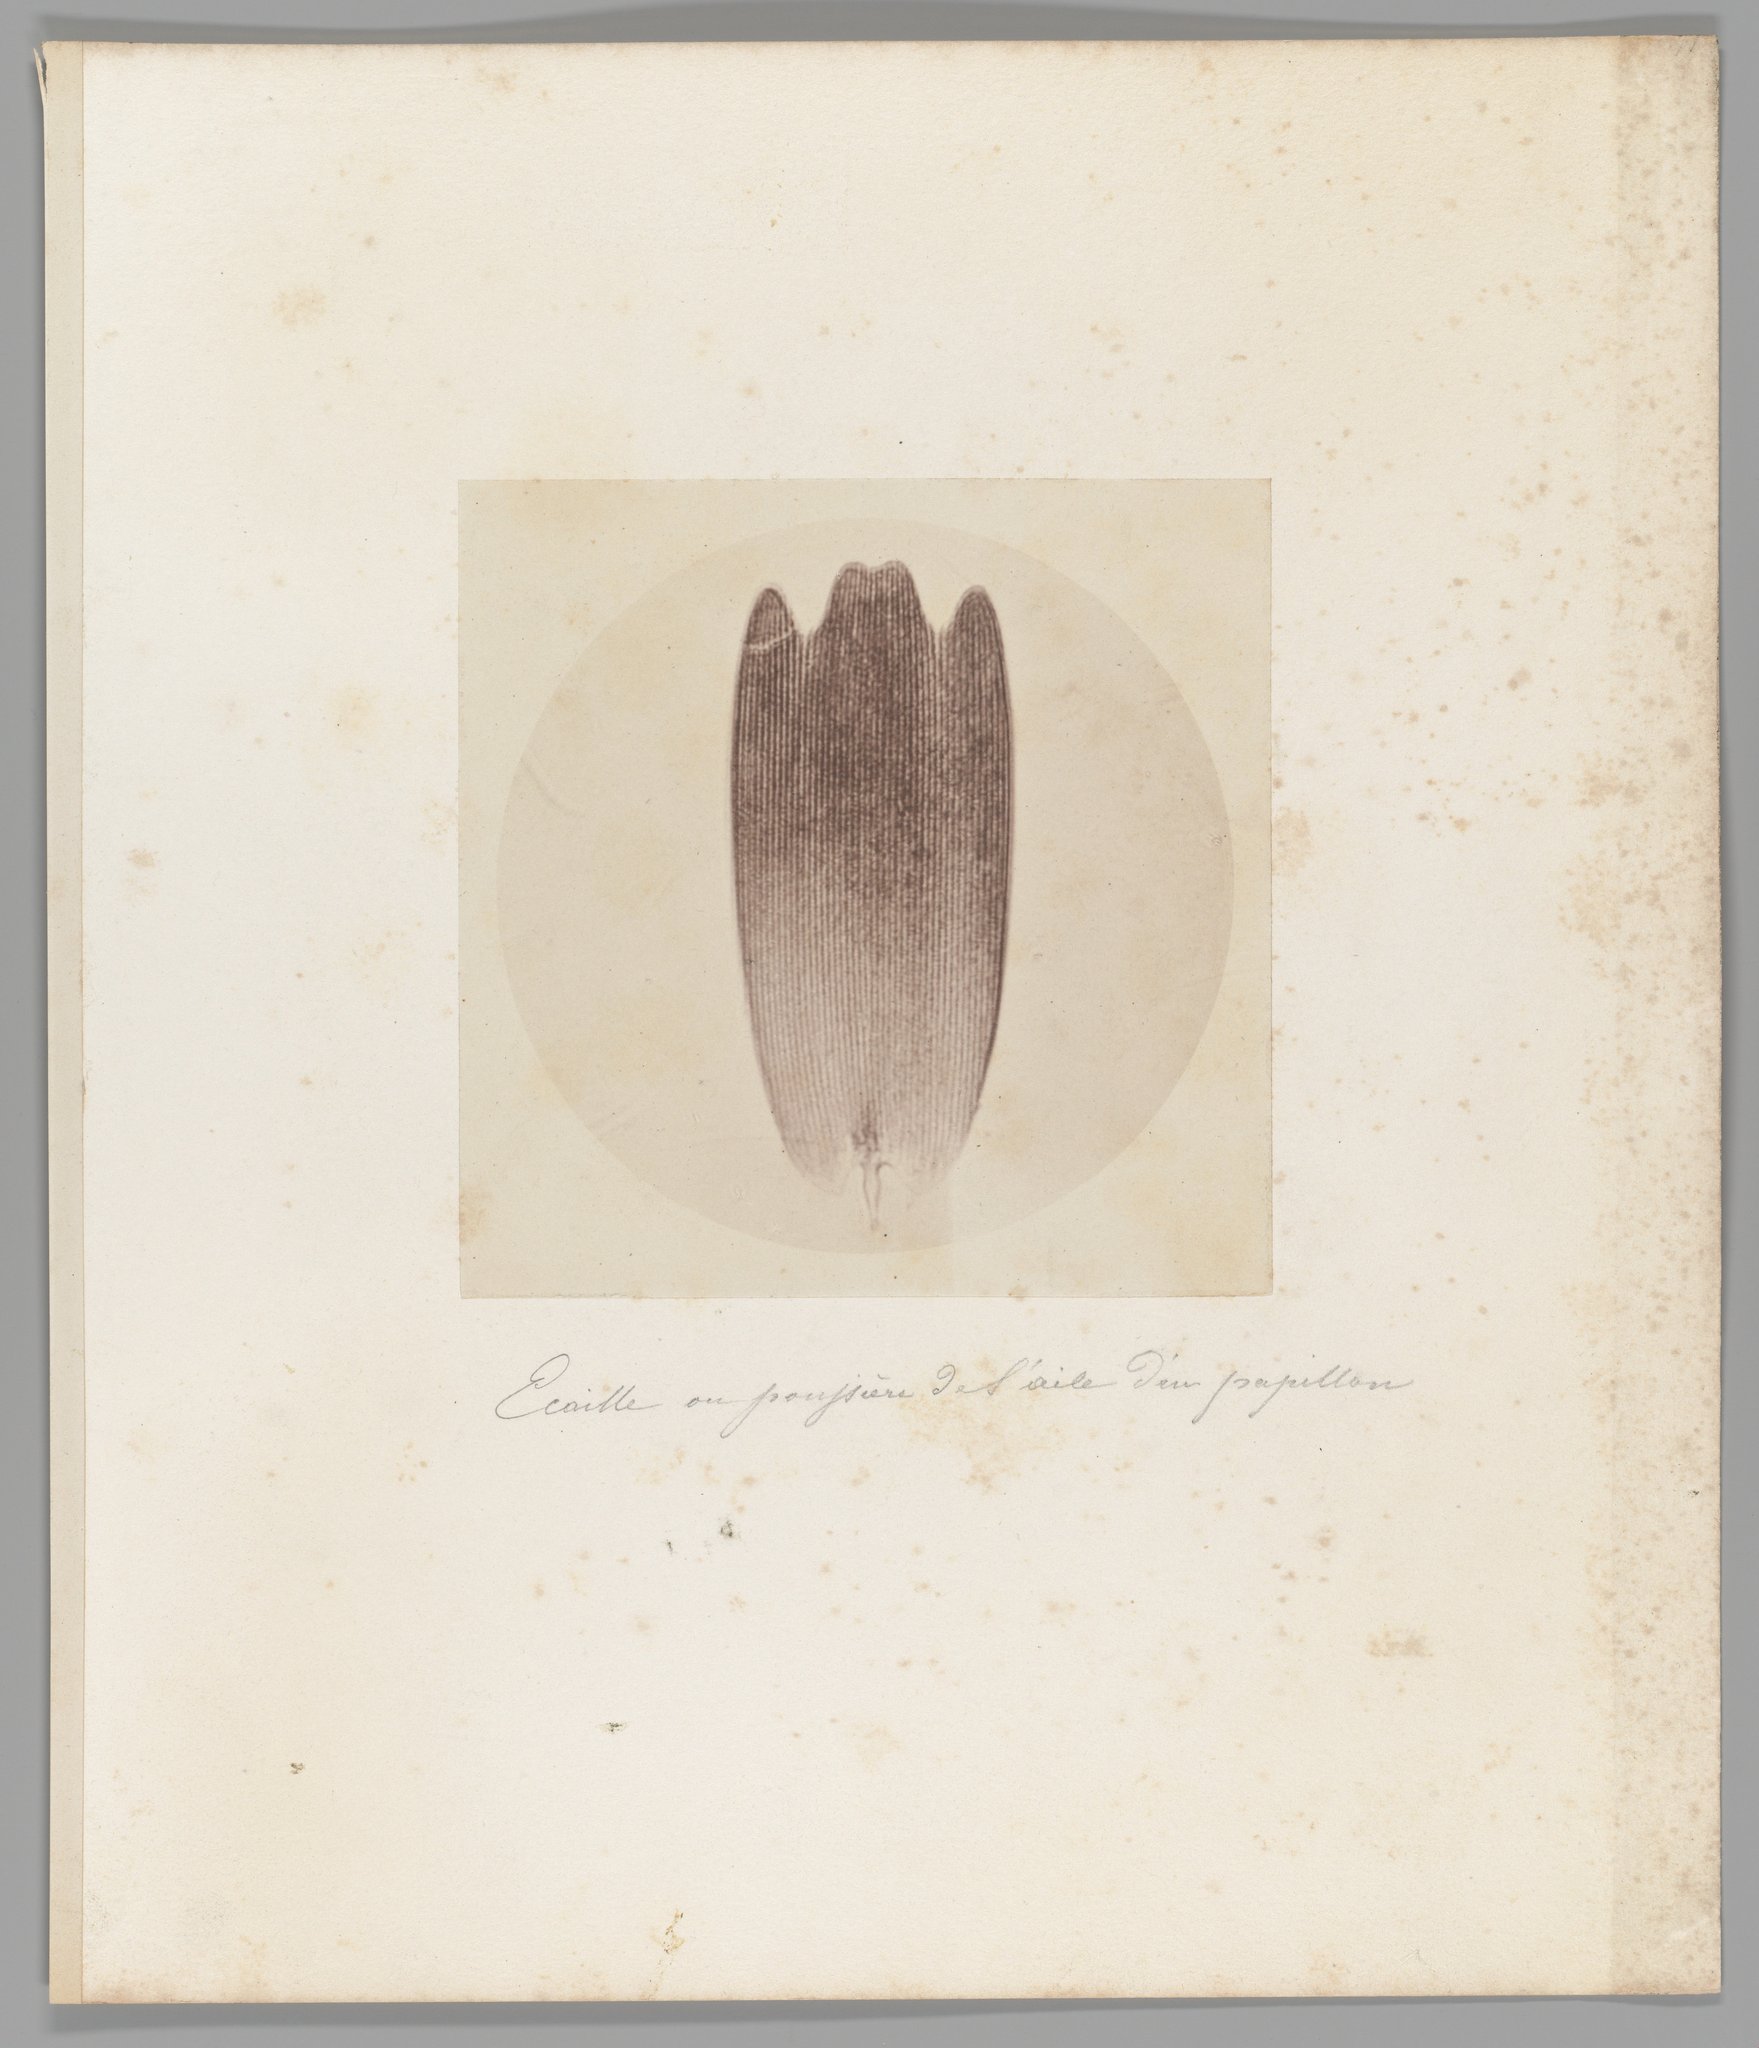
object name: photograph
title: [Untitled]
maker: auguste-adolphe bertsch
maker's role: artist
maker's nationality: french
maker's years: 1813-1871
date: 1853-1857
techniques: salted paper print